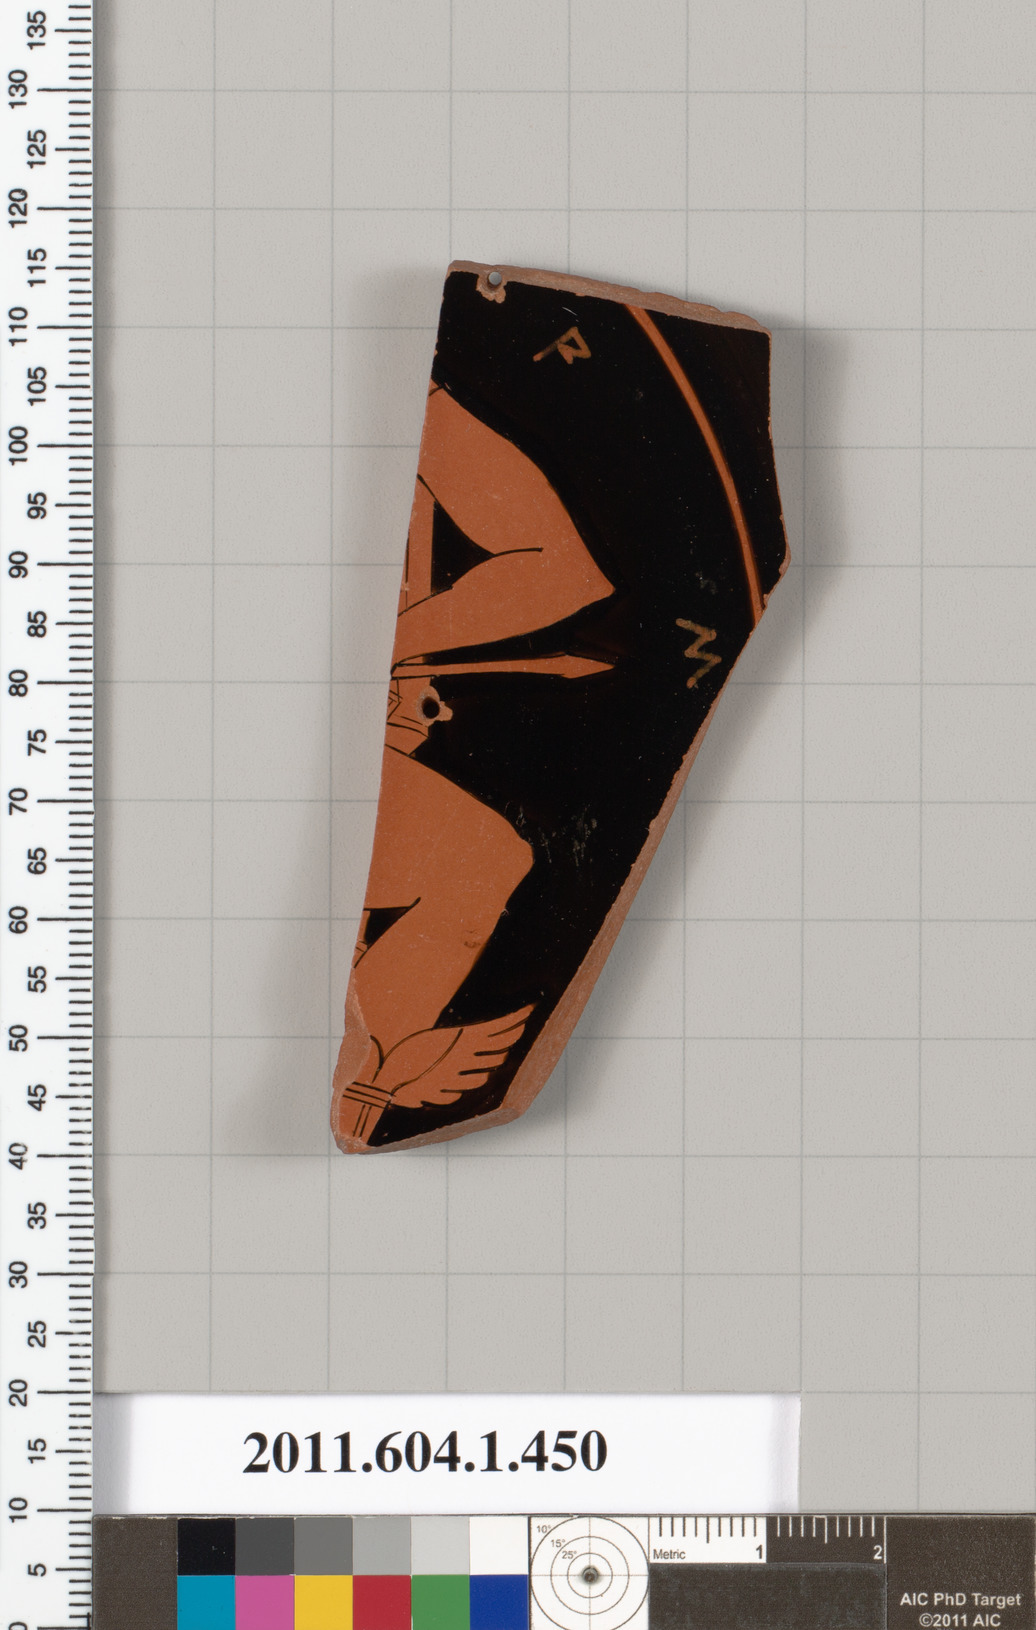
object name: kylix fragment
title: Terracotta fragment of a kylix (drinking cup)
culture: greek, attic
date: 520-500 BCE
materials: terracotta